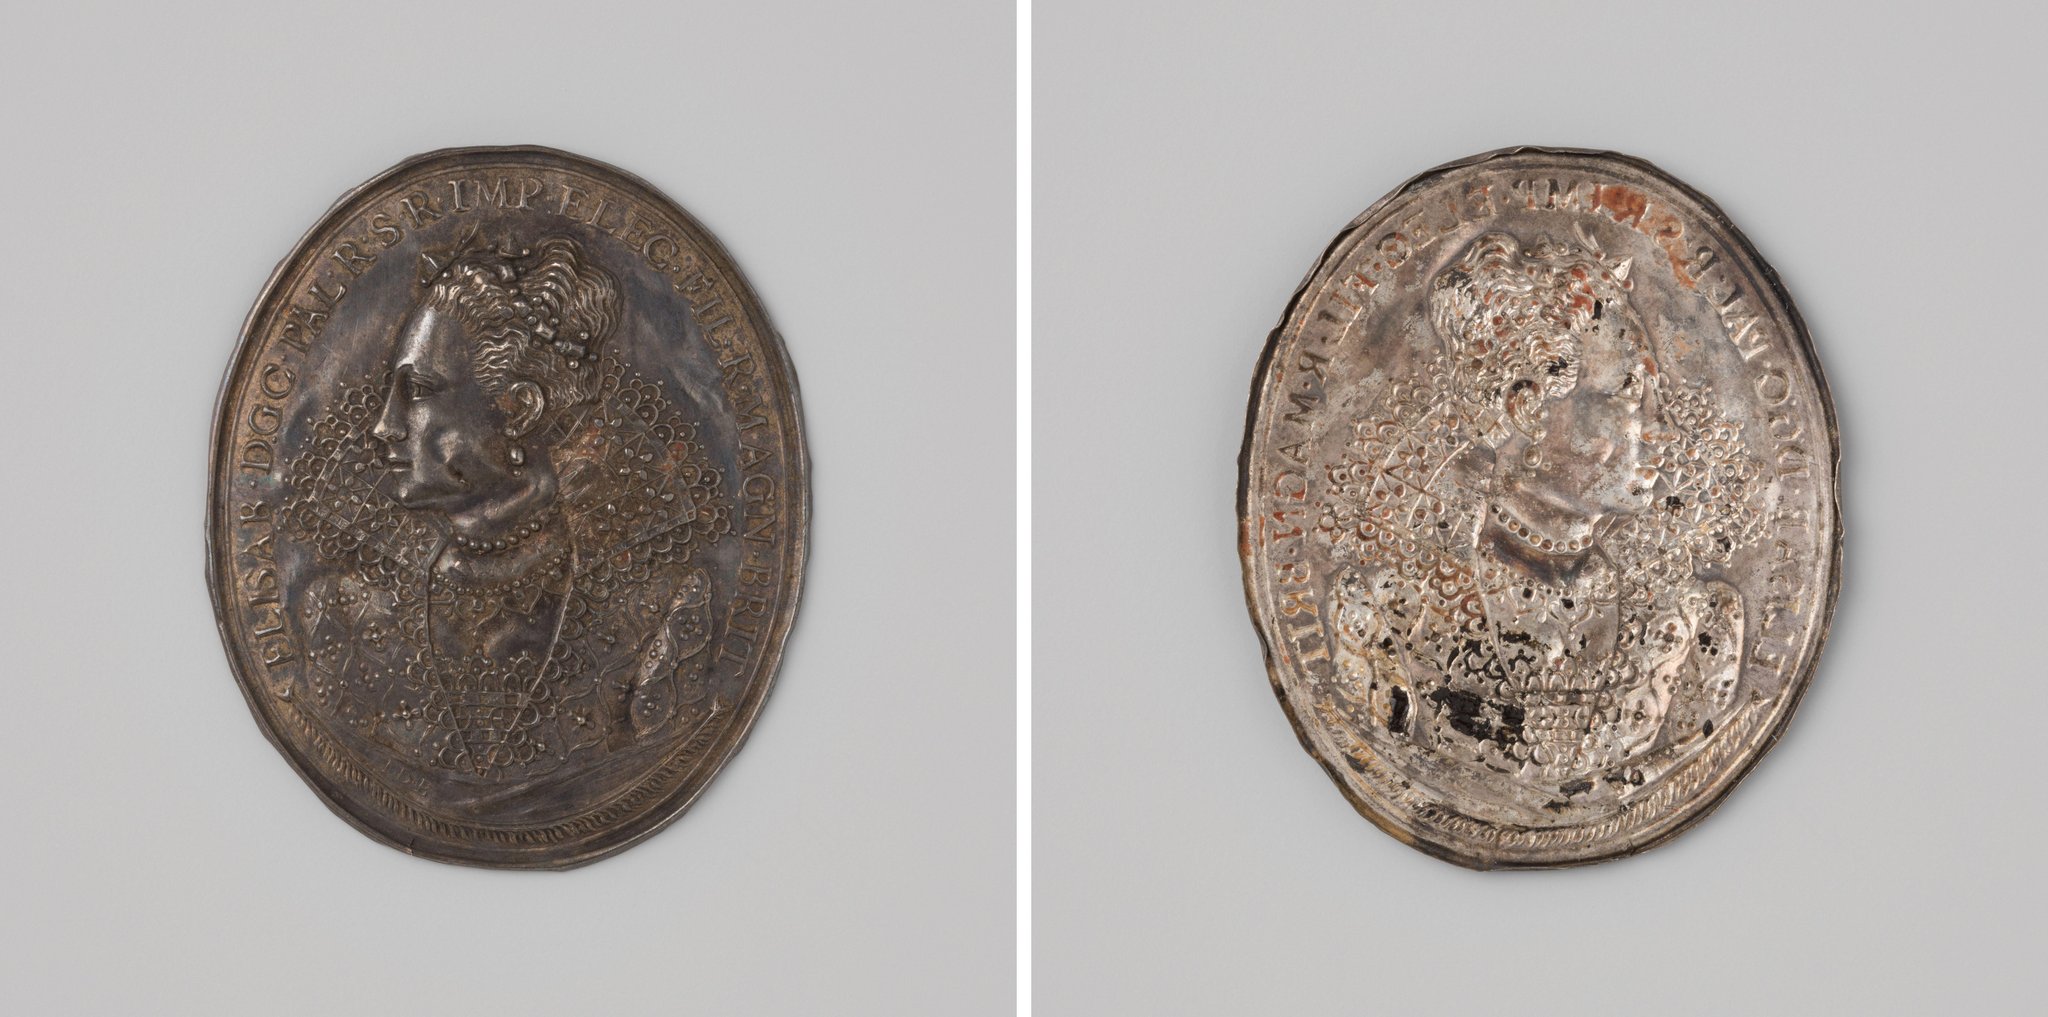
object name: copy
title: Huwelijk van Frederik van de Palts met Elisabeth van Engeland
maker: monogrammist idb (medailleur)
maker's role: medailleur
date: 1613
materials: silver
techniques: galvanoplasty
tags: amberg, frederik v (keurvorst van de palts, koning van bohemen), london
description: Zilveren ovale penning. Voorzijde: borststuk vrouw binnen omschrift